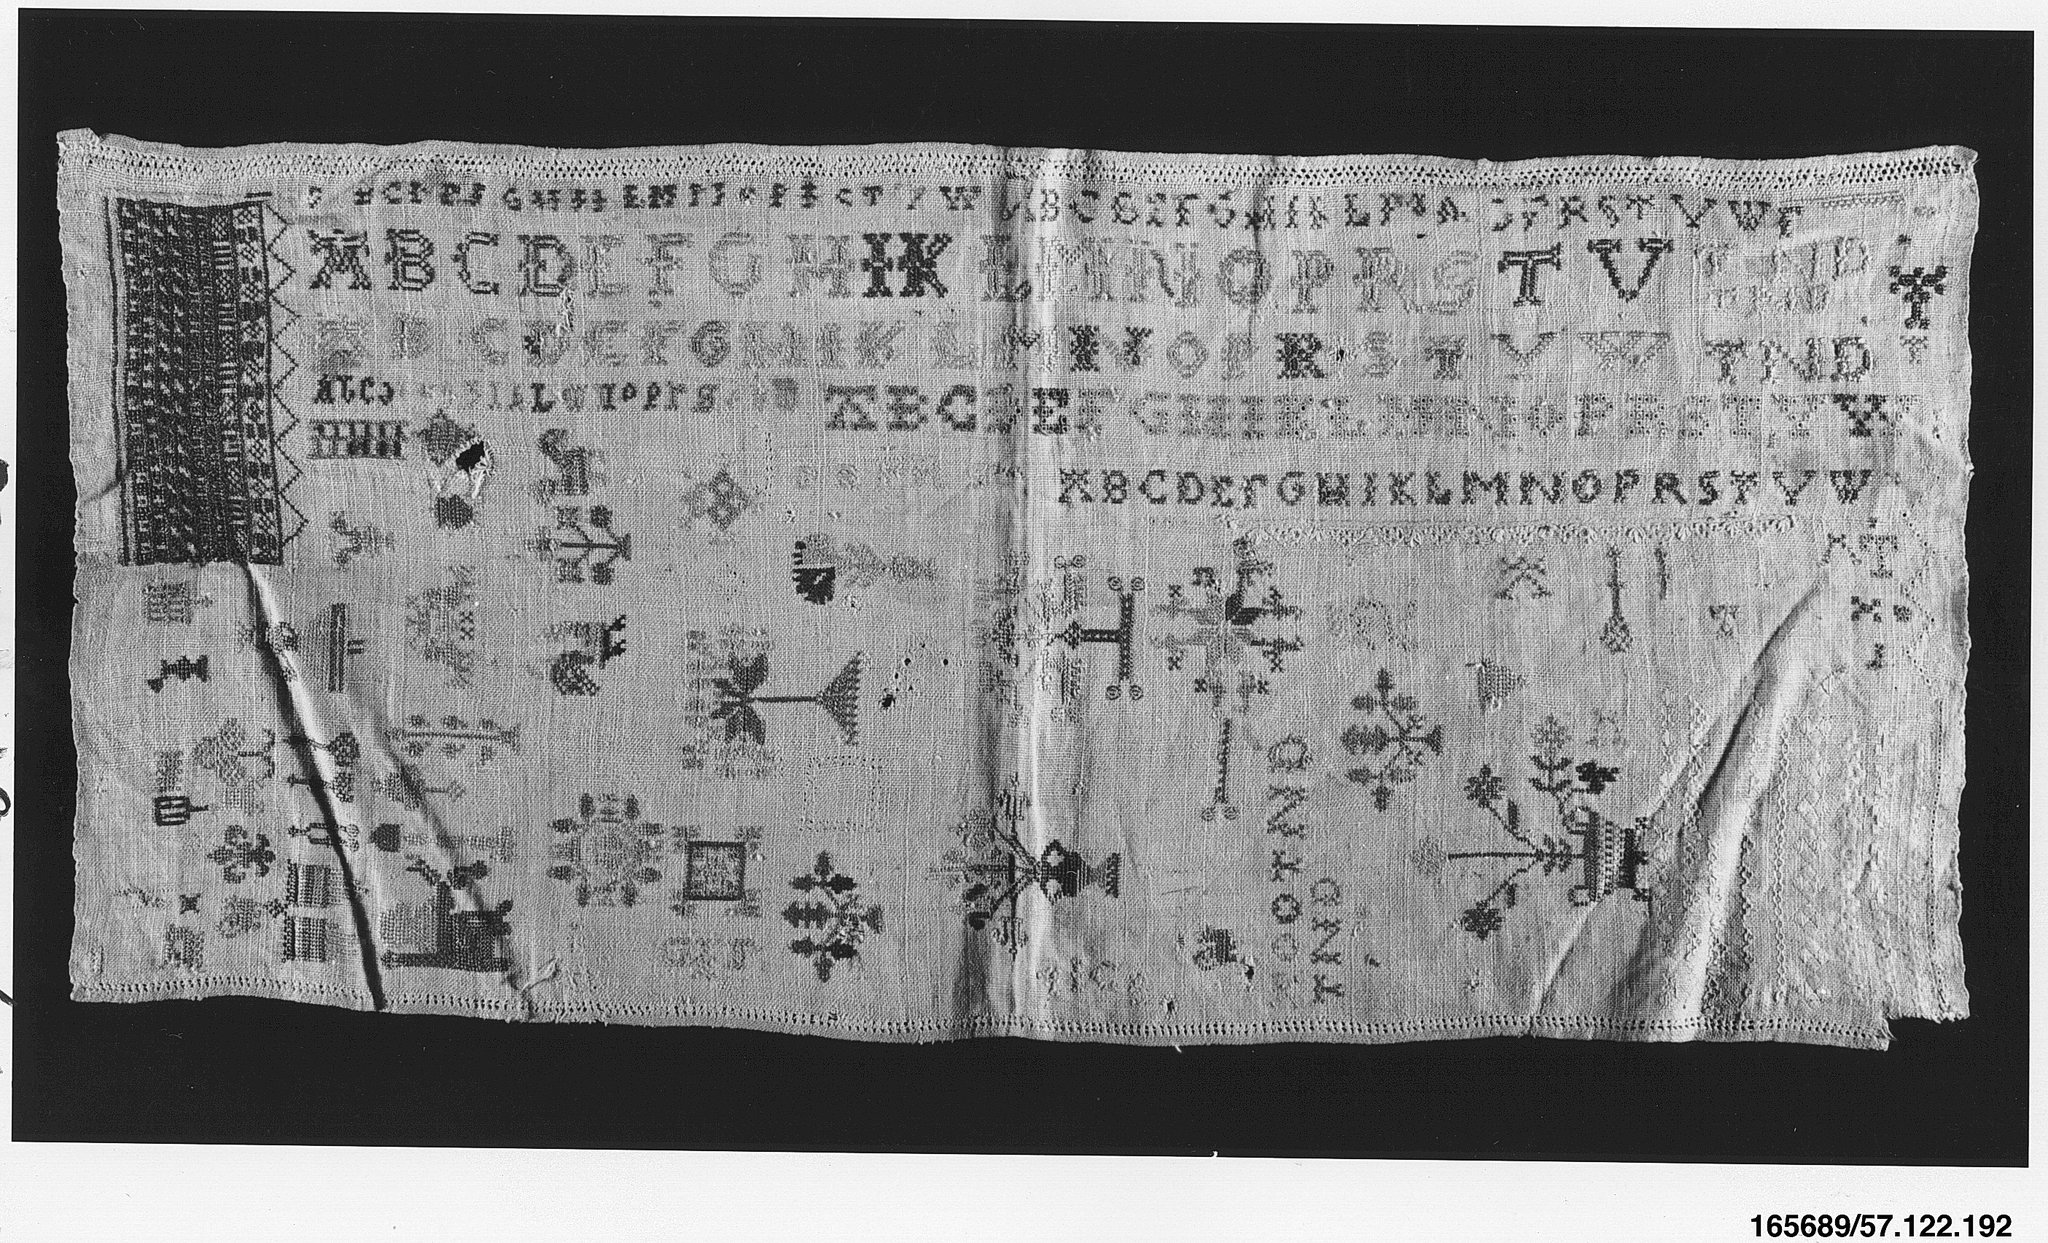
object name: sampler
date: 1701-1800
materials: linen, silk